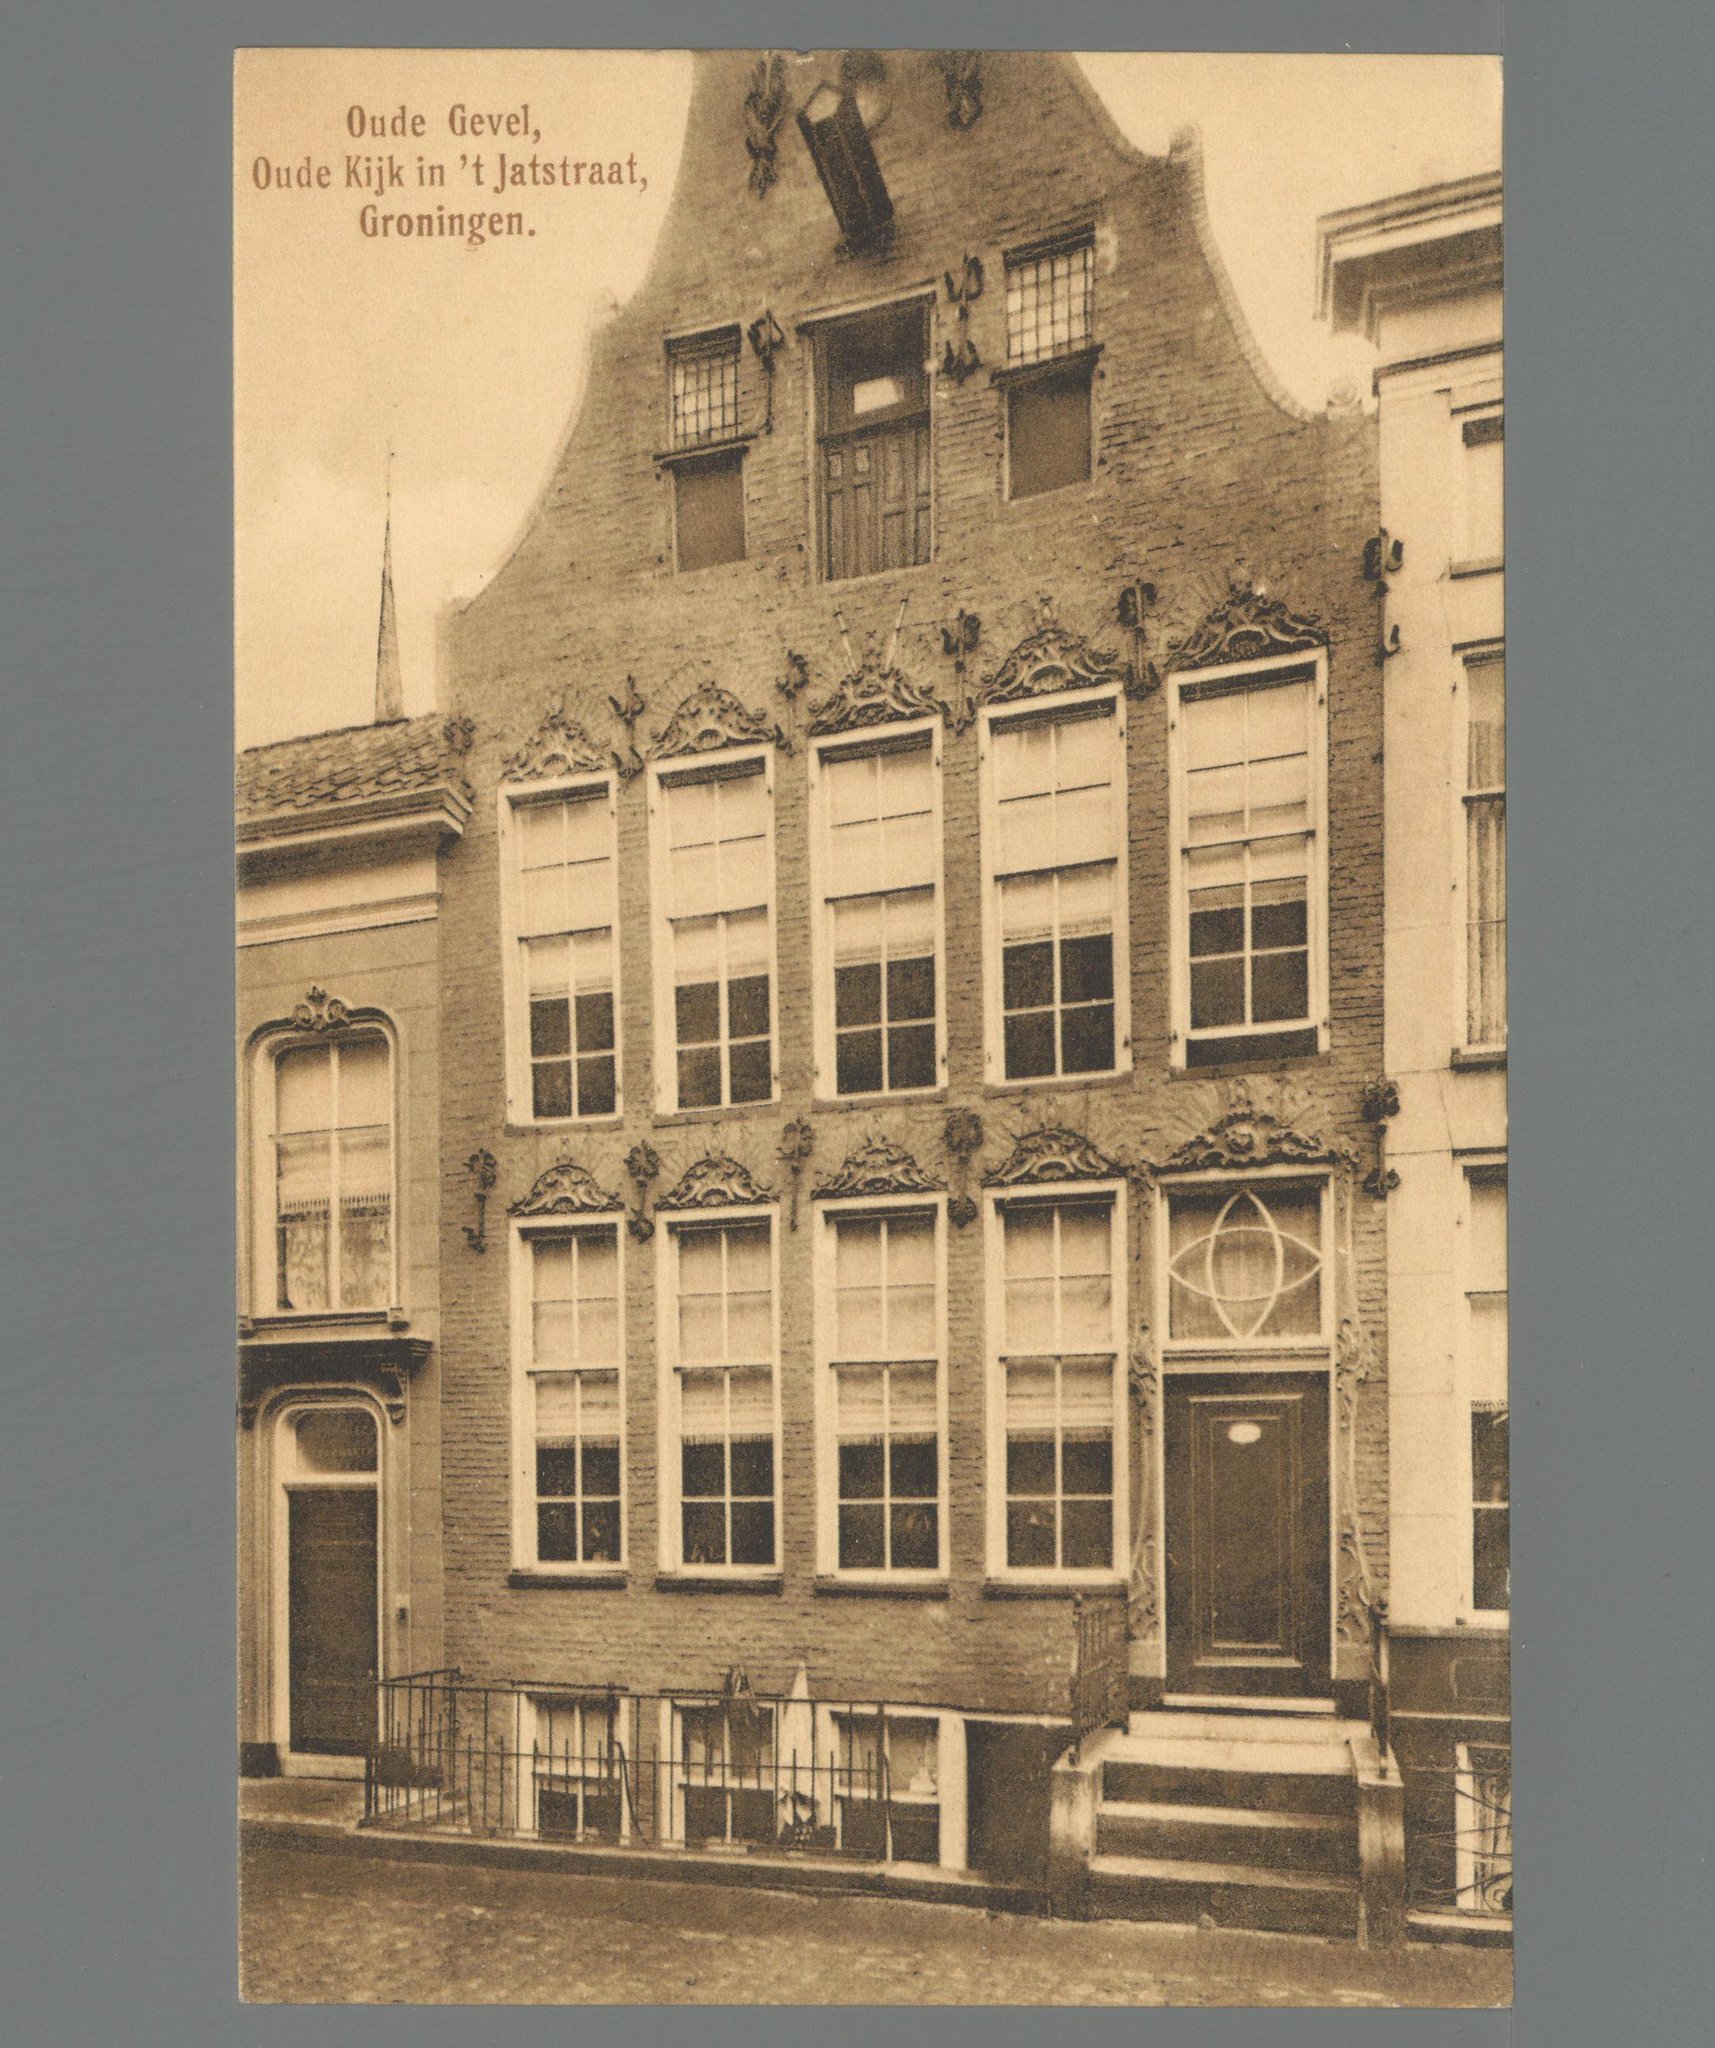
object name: ansichtkaart, prentbriefkaart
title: Oude gevel, Oude Kijk in 't Jatstraat, Groningen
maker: Anonymous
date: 1905-1930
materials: cardboard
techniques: photograph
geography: groningen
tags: façade (of house or building)